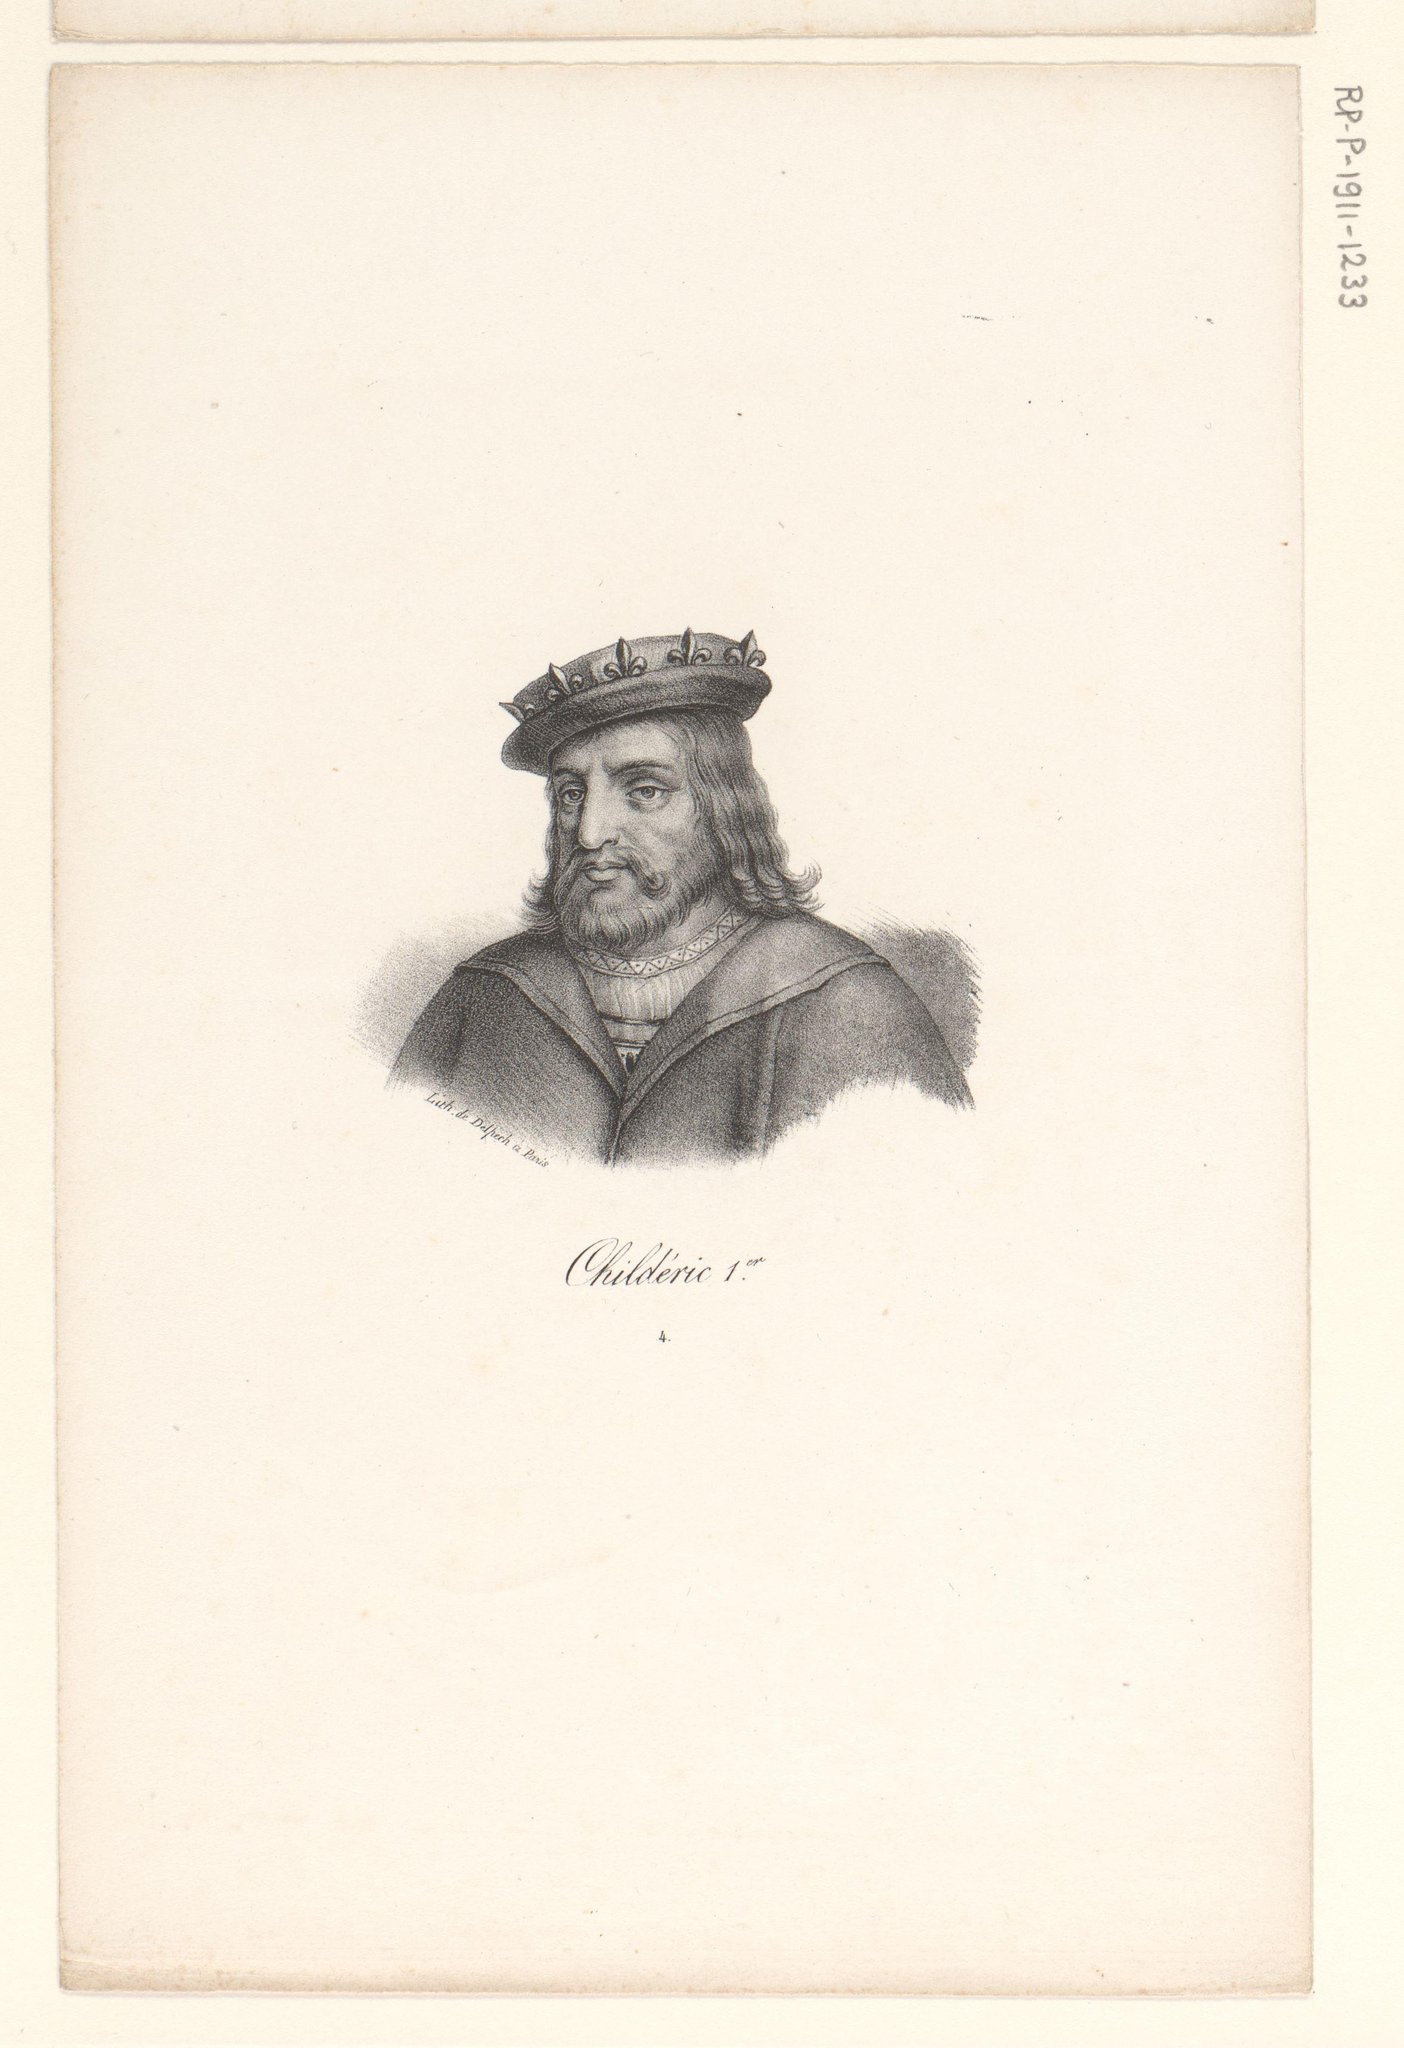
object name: print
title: Portret van koning Childerik I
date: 1818-1842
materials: paper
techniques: lithograph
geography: paris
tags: historical persons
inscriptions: collector's mark: Lugt 2228a